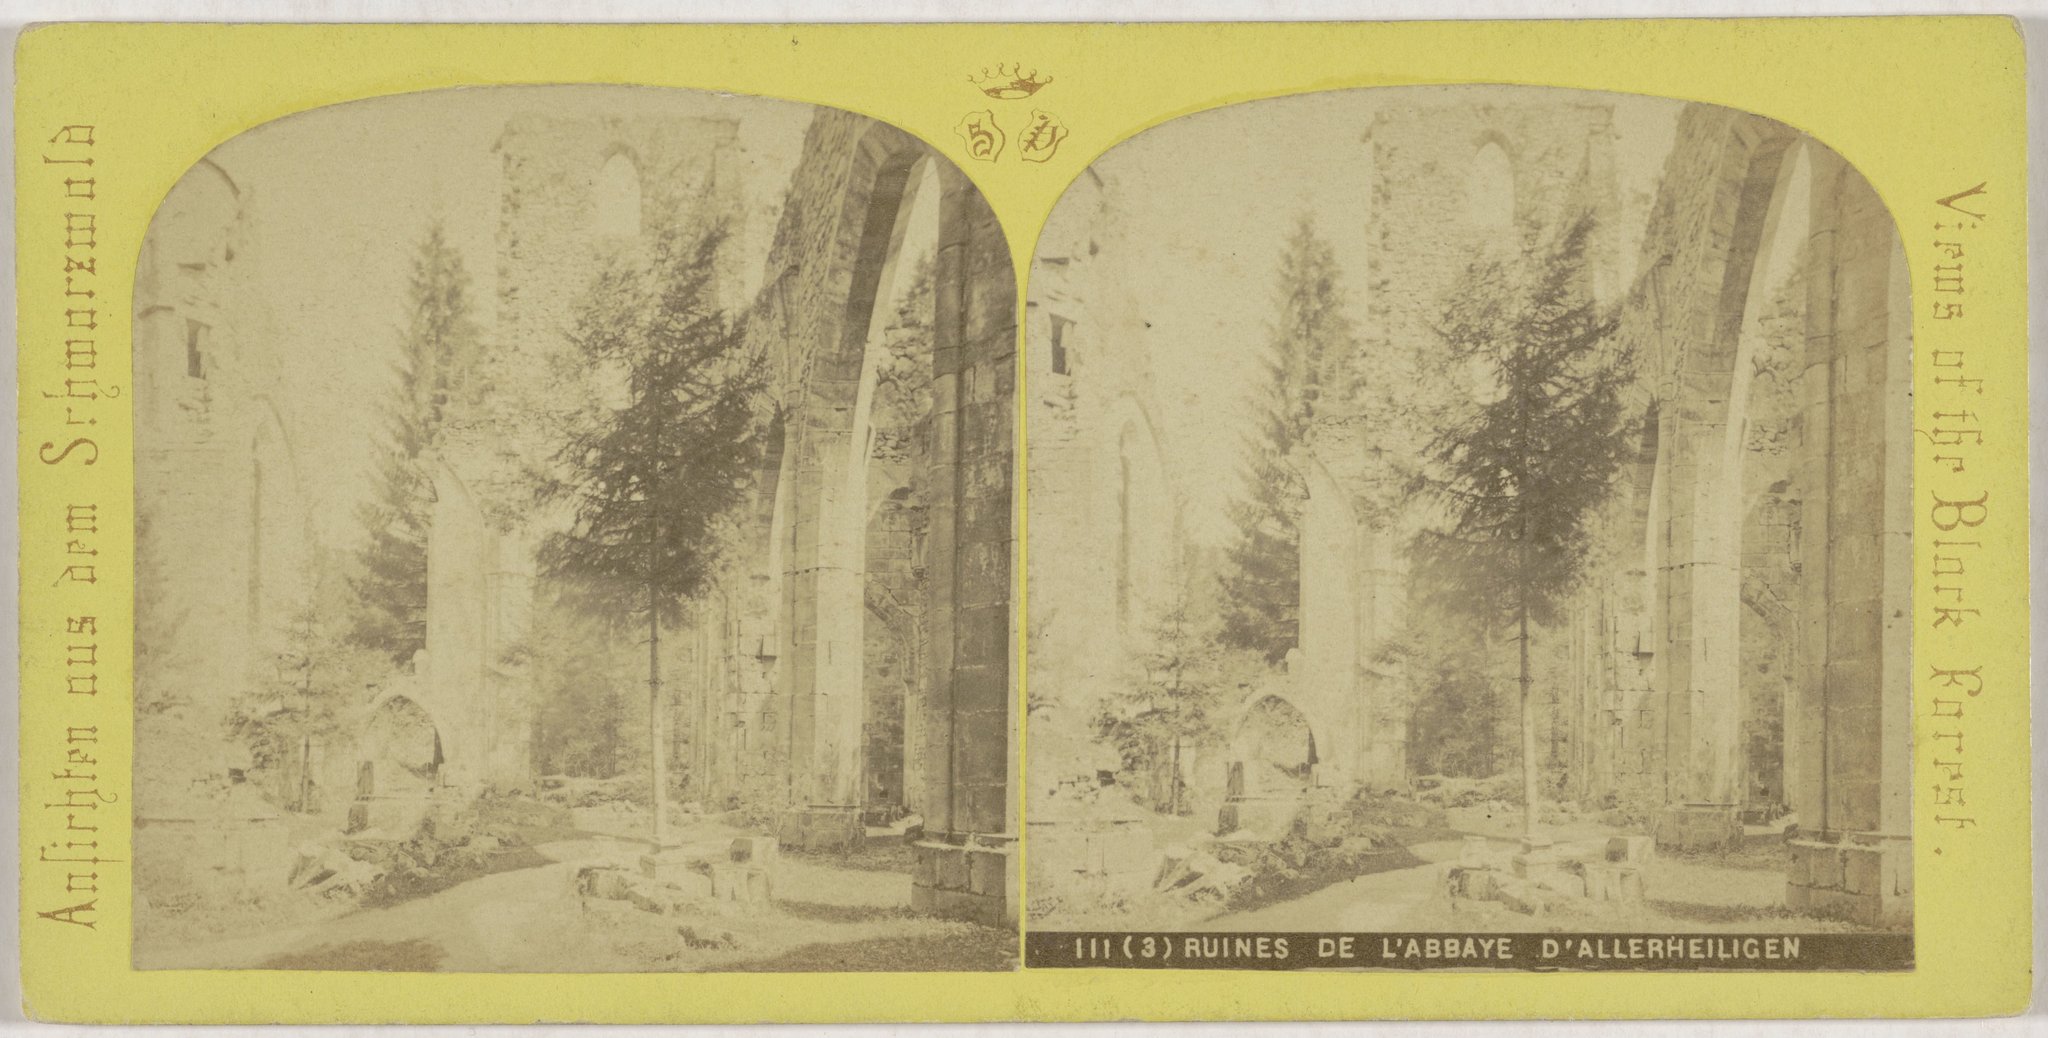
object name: stereograph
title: Ruines de l'Abbaye d'Allerheiligen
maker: sp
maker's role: fotograaf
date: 1861-1870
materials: cardboard, paper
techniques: albumen print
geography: oppenau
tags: ruin of church, monastery, etc.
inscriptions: number: ‘111 (3)’